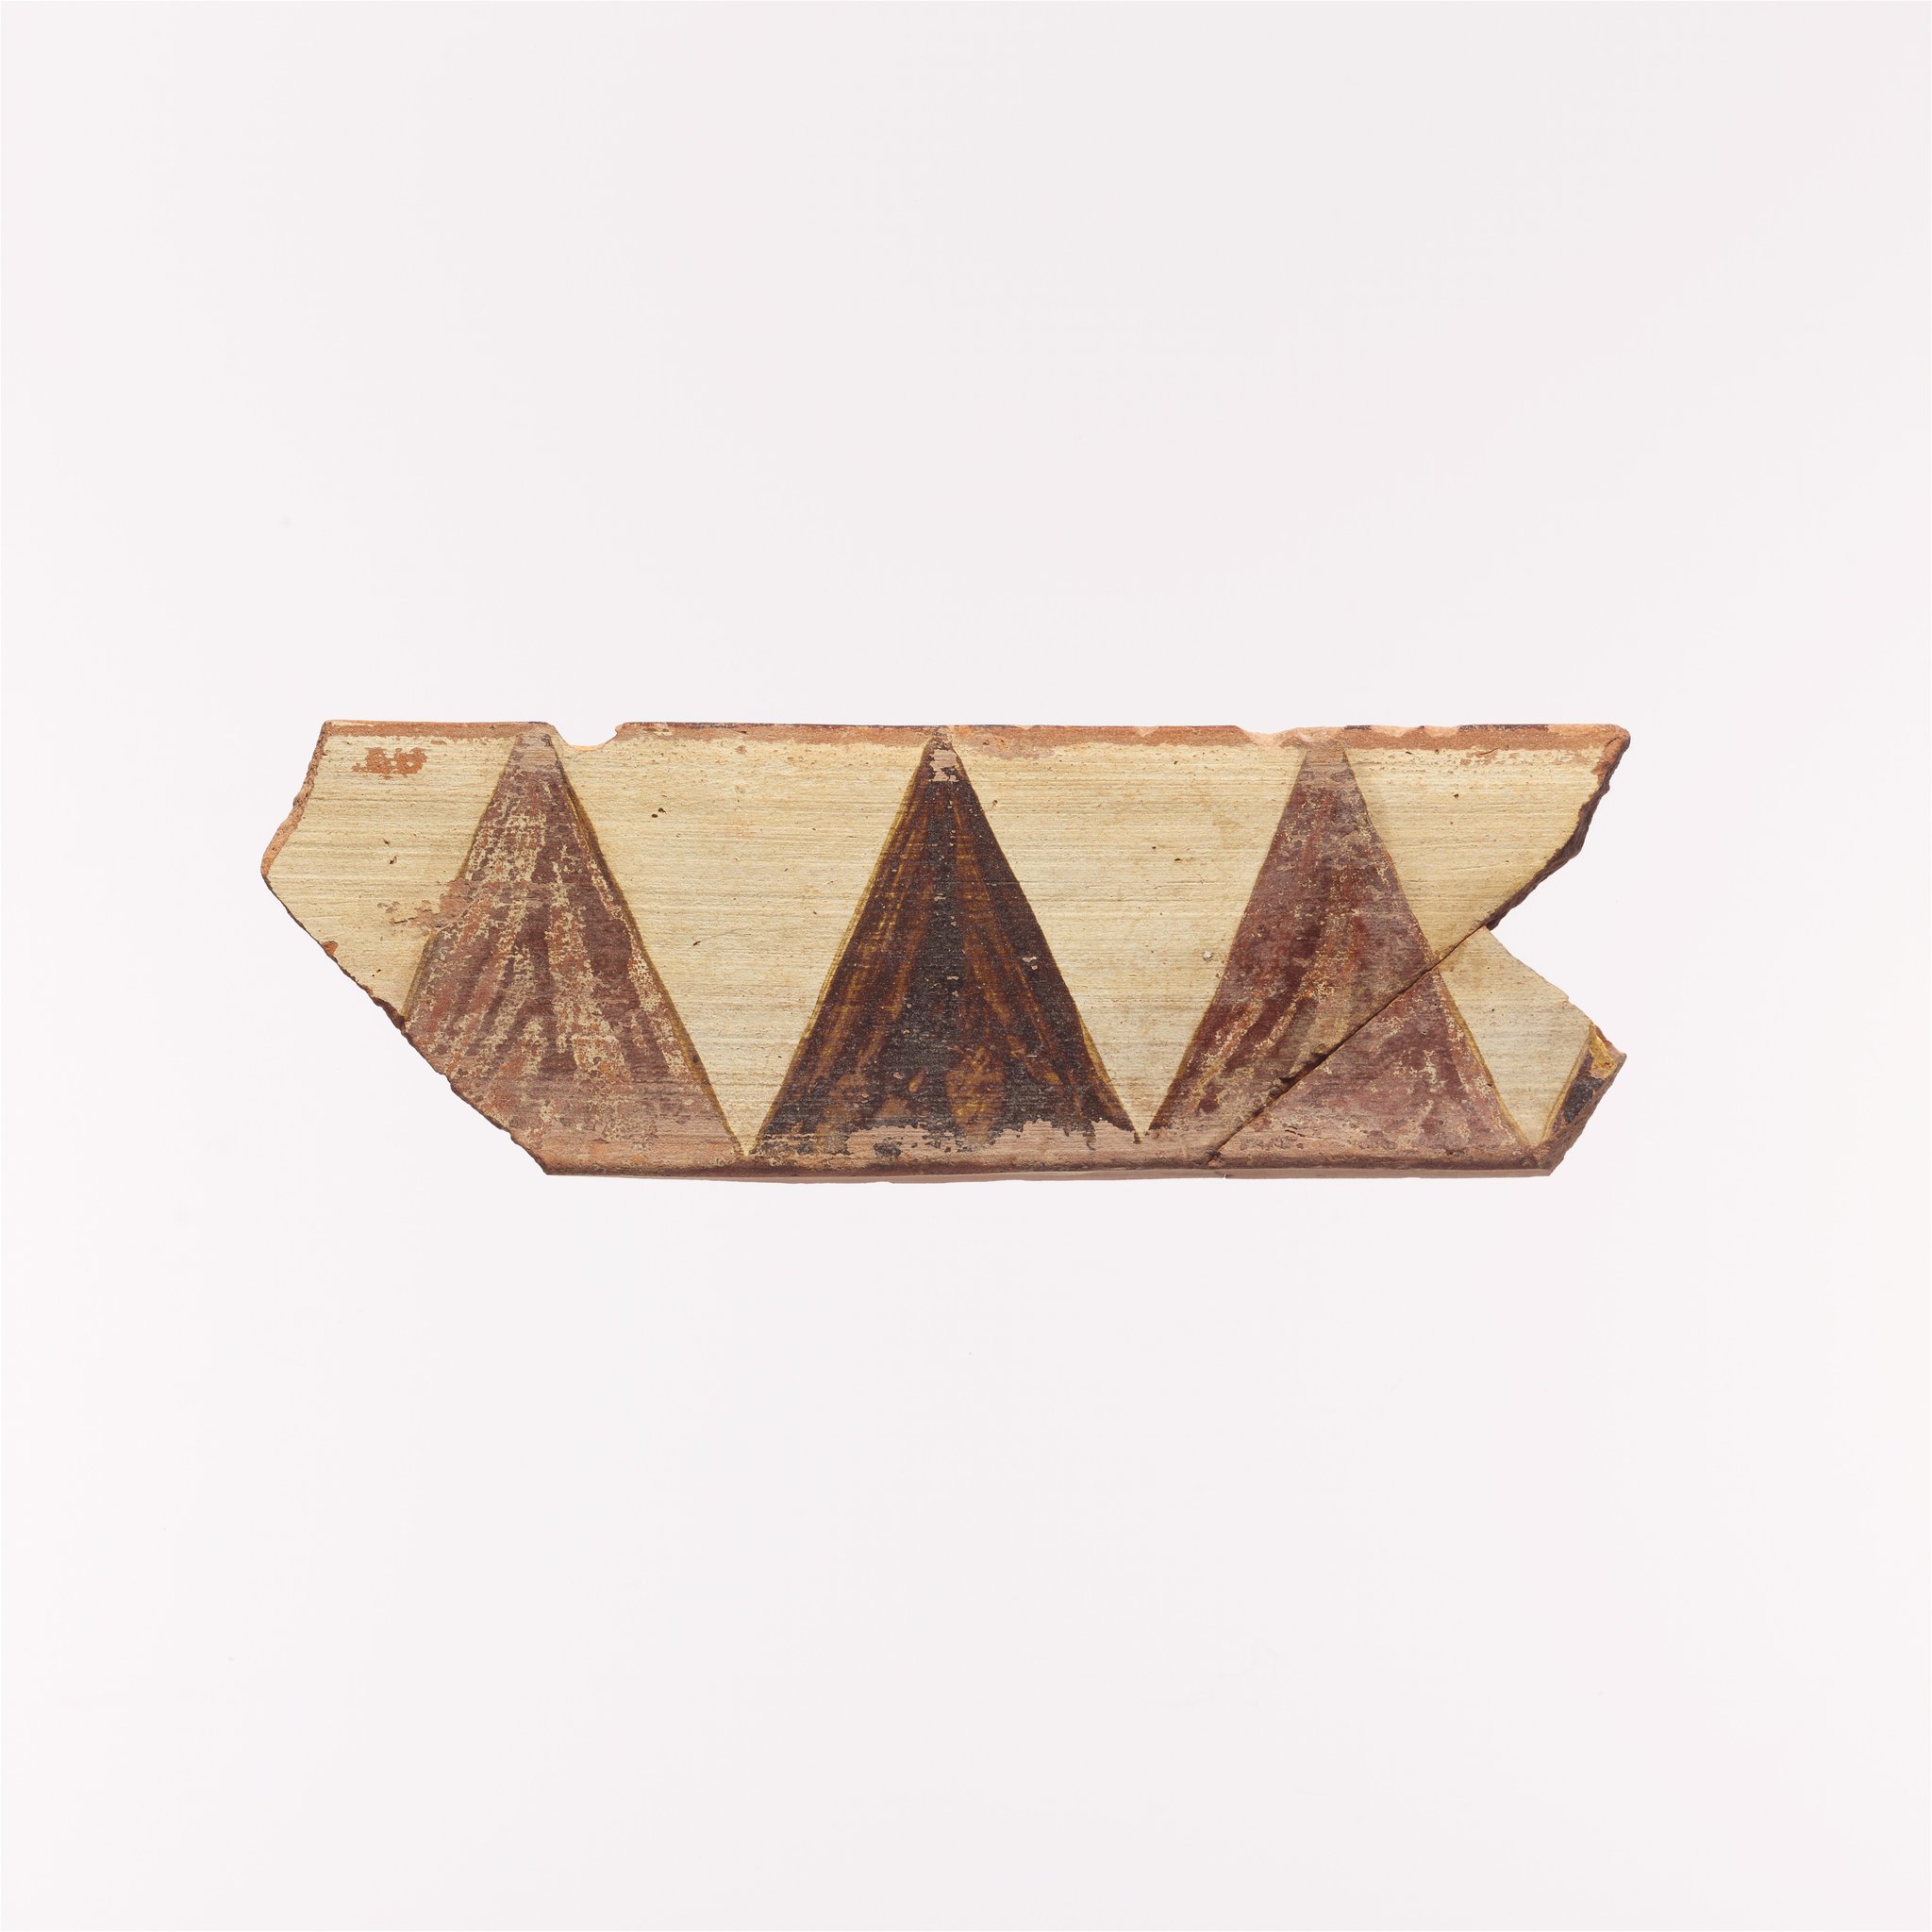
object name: tile fragment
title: Fragment of a terracotta architectural tile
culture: lydian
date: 600-501 BCE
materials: terracotta